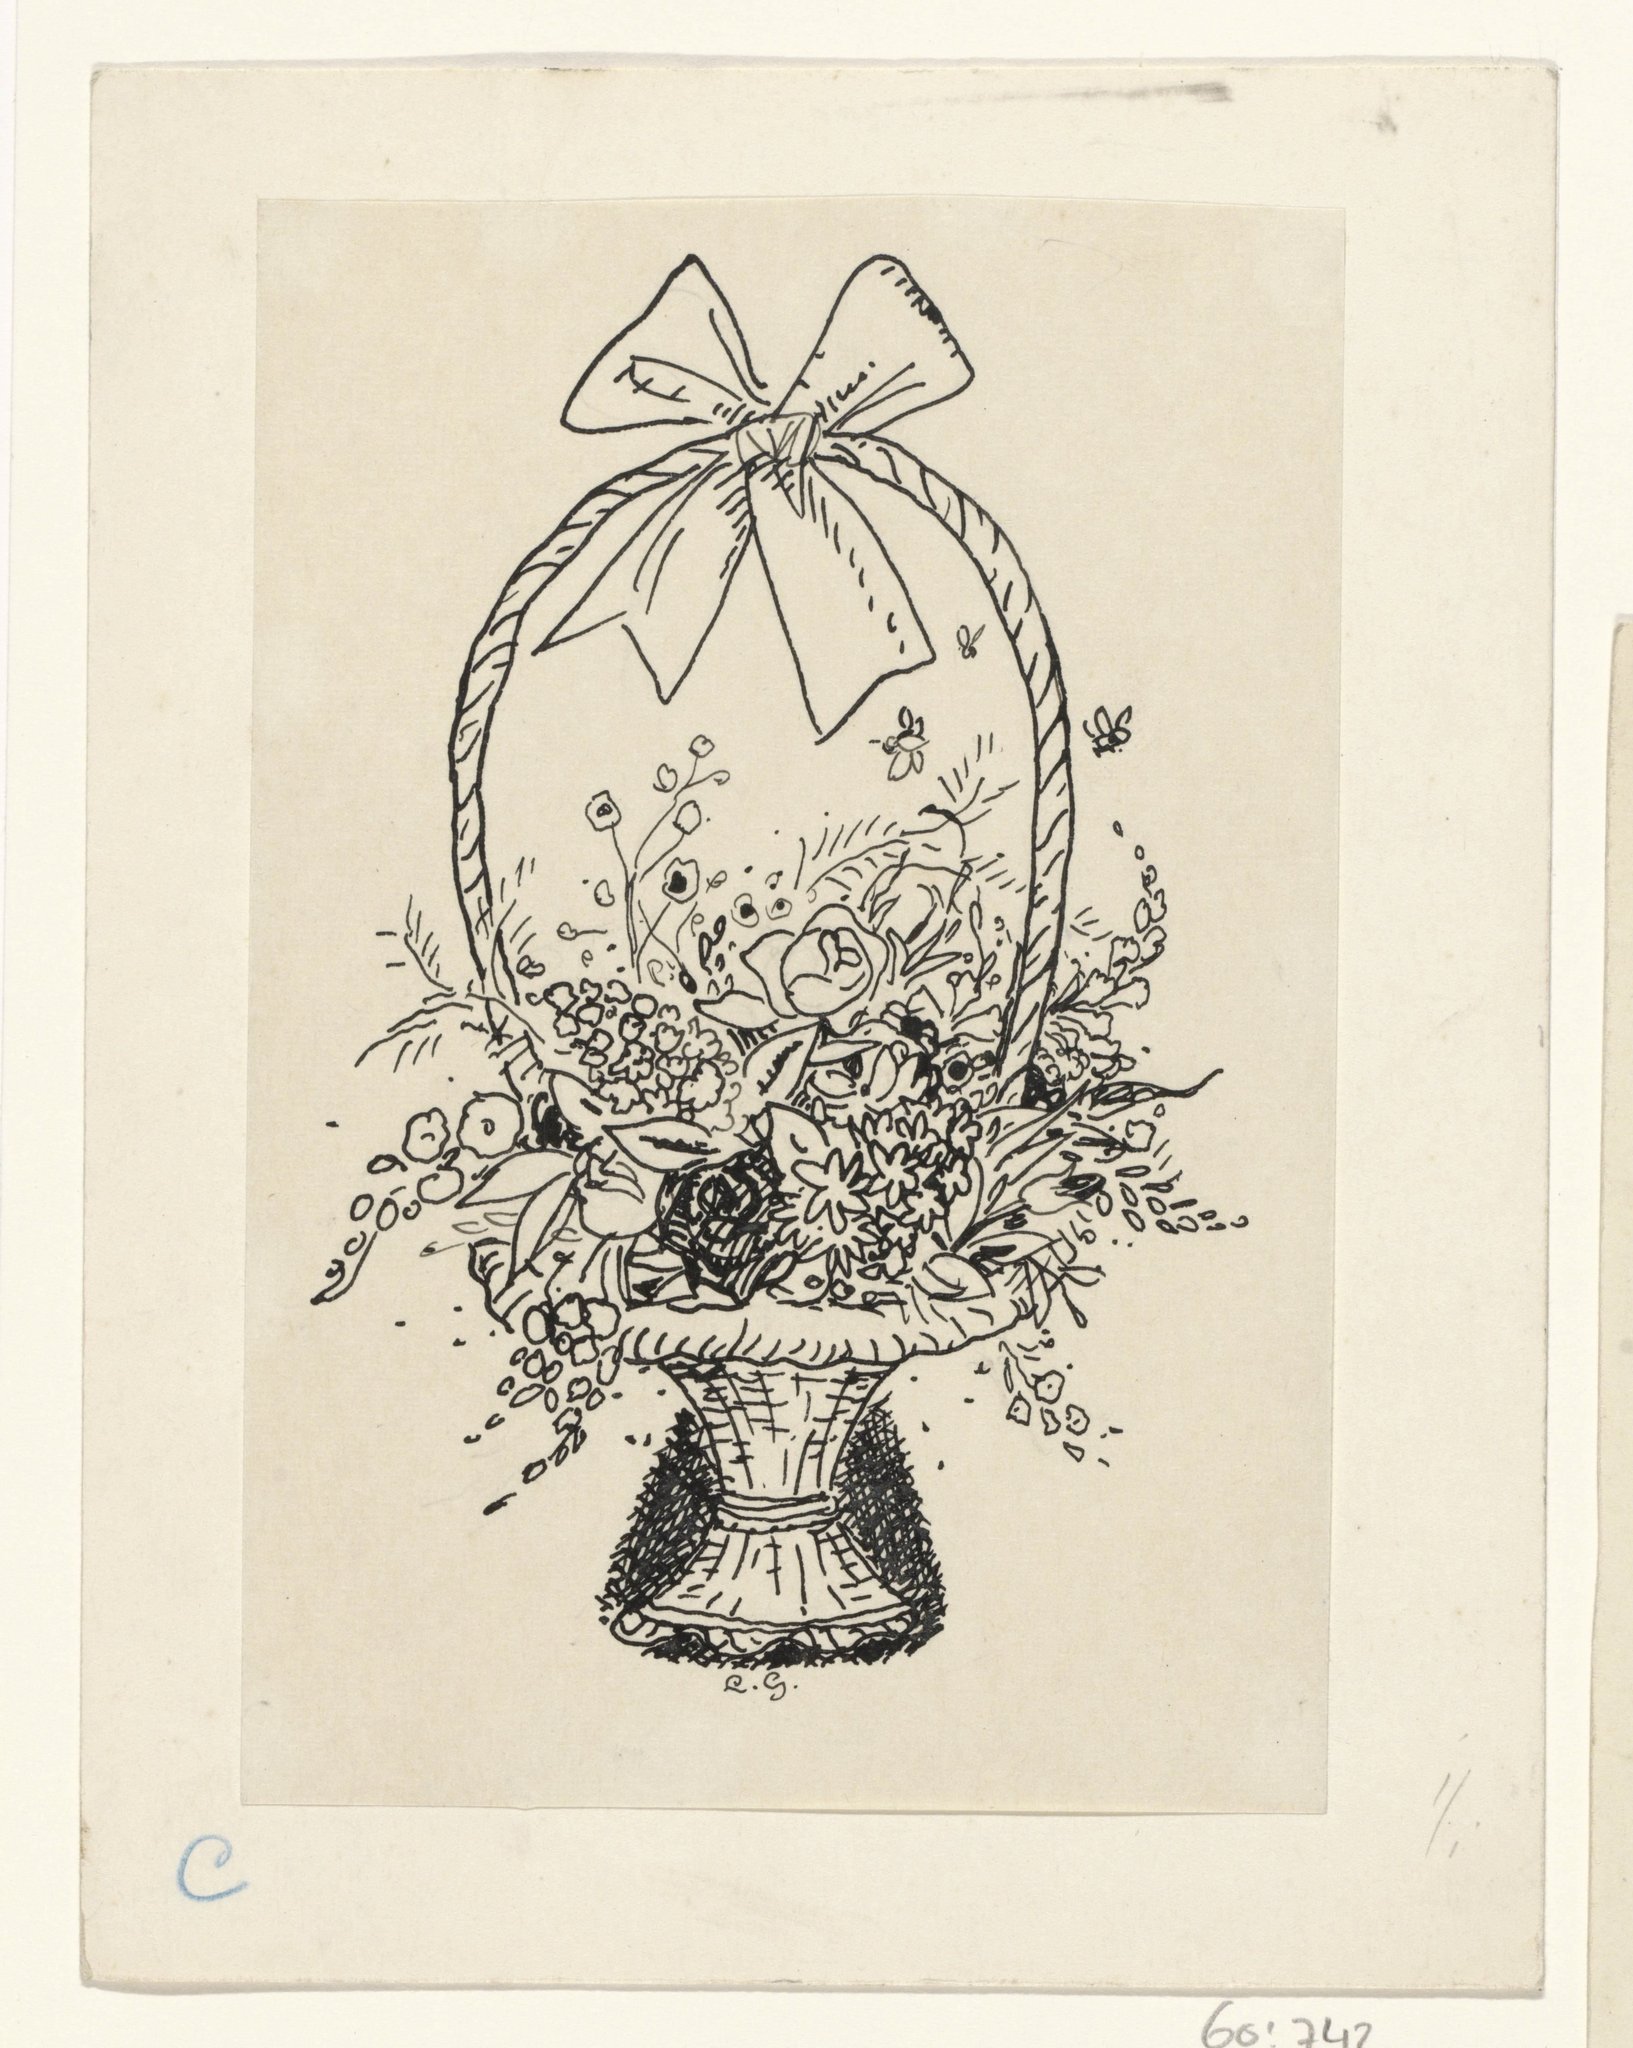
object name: design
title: Mand met bloemen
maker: leo gestel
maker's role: draughtsman, print maker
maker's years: 1881-1941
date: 1891-1941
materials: ink, paper, pencil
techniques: pen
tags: cut flowers; nosegay, bunch of flowers, container made of plant material other than wood: basket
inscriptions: collector's mark: Lugt 2228